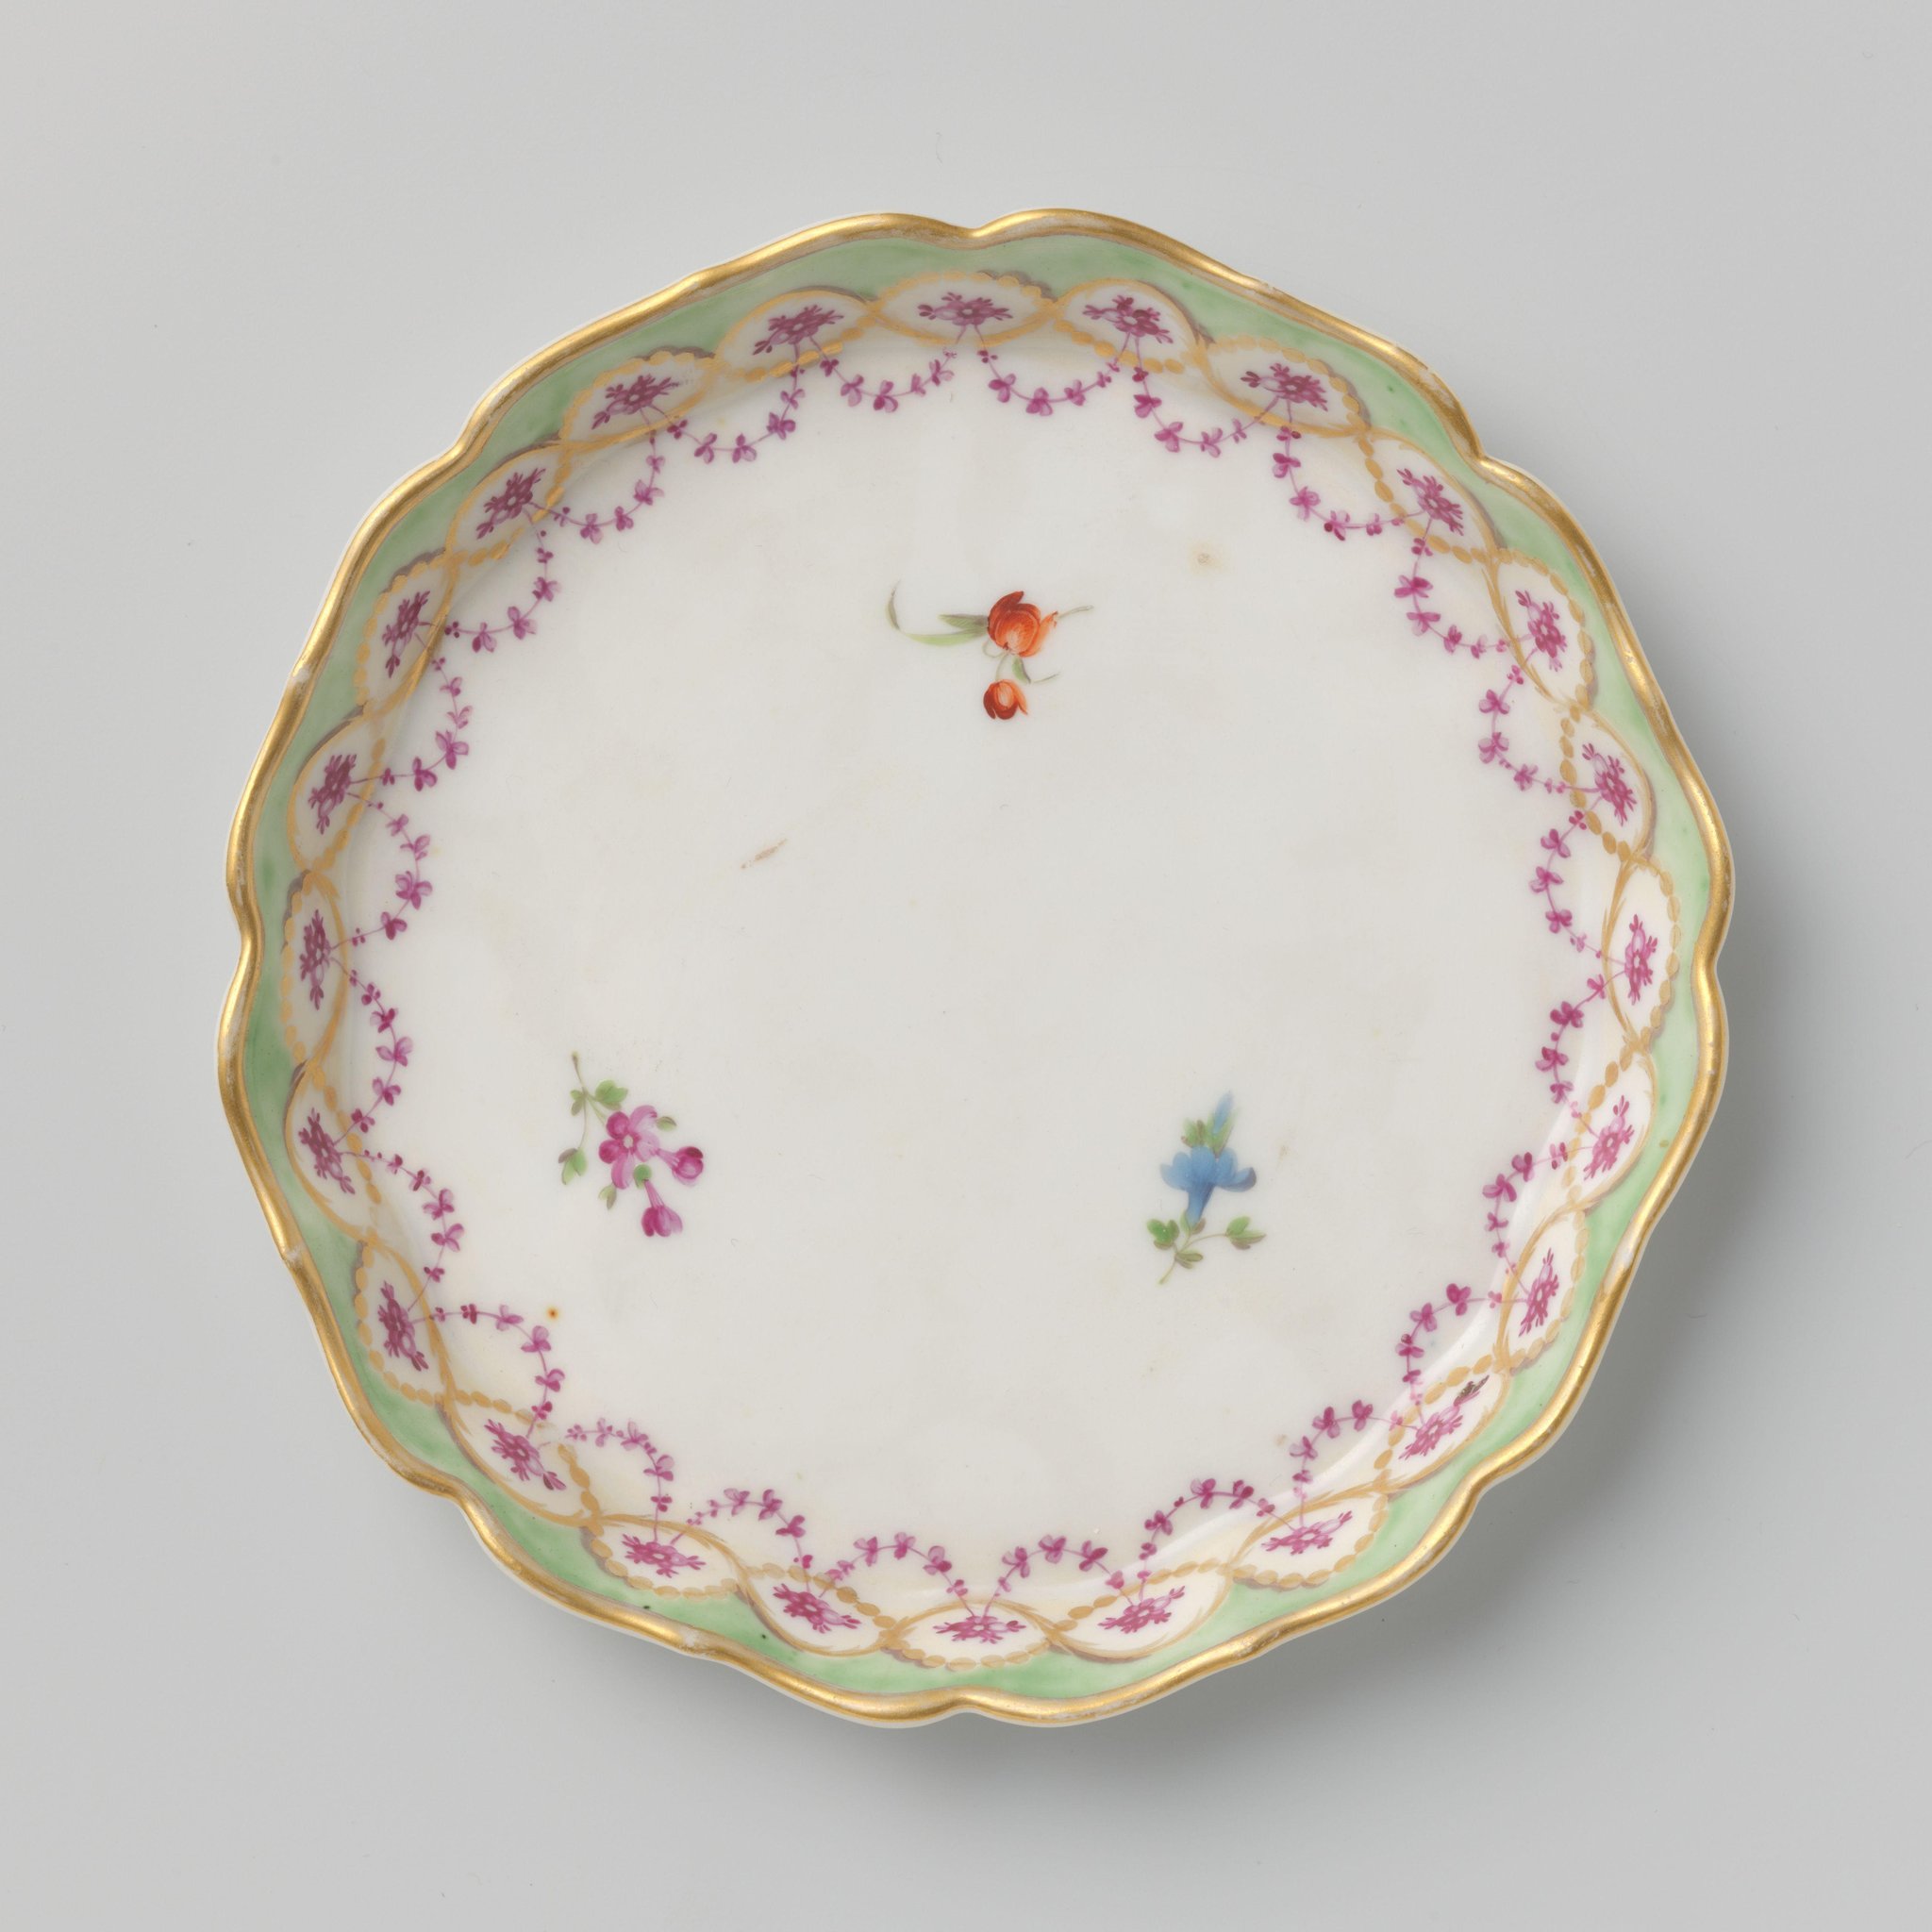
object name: vessel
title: Pattipan van theeservies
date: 1784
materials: porcelain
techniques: painted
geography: loosdrecht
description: Pattipan van theeservies voor suikerpot met deksel. De versiering bestaat uit strooibloemen op het plat en langs de rand een geornamenteerde band.